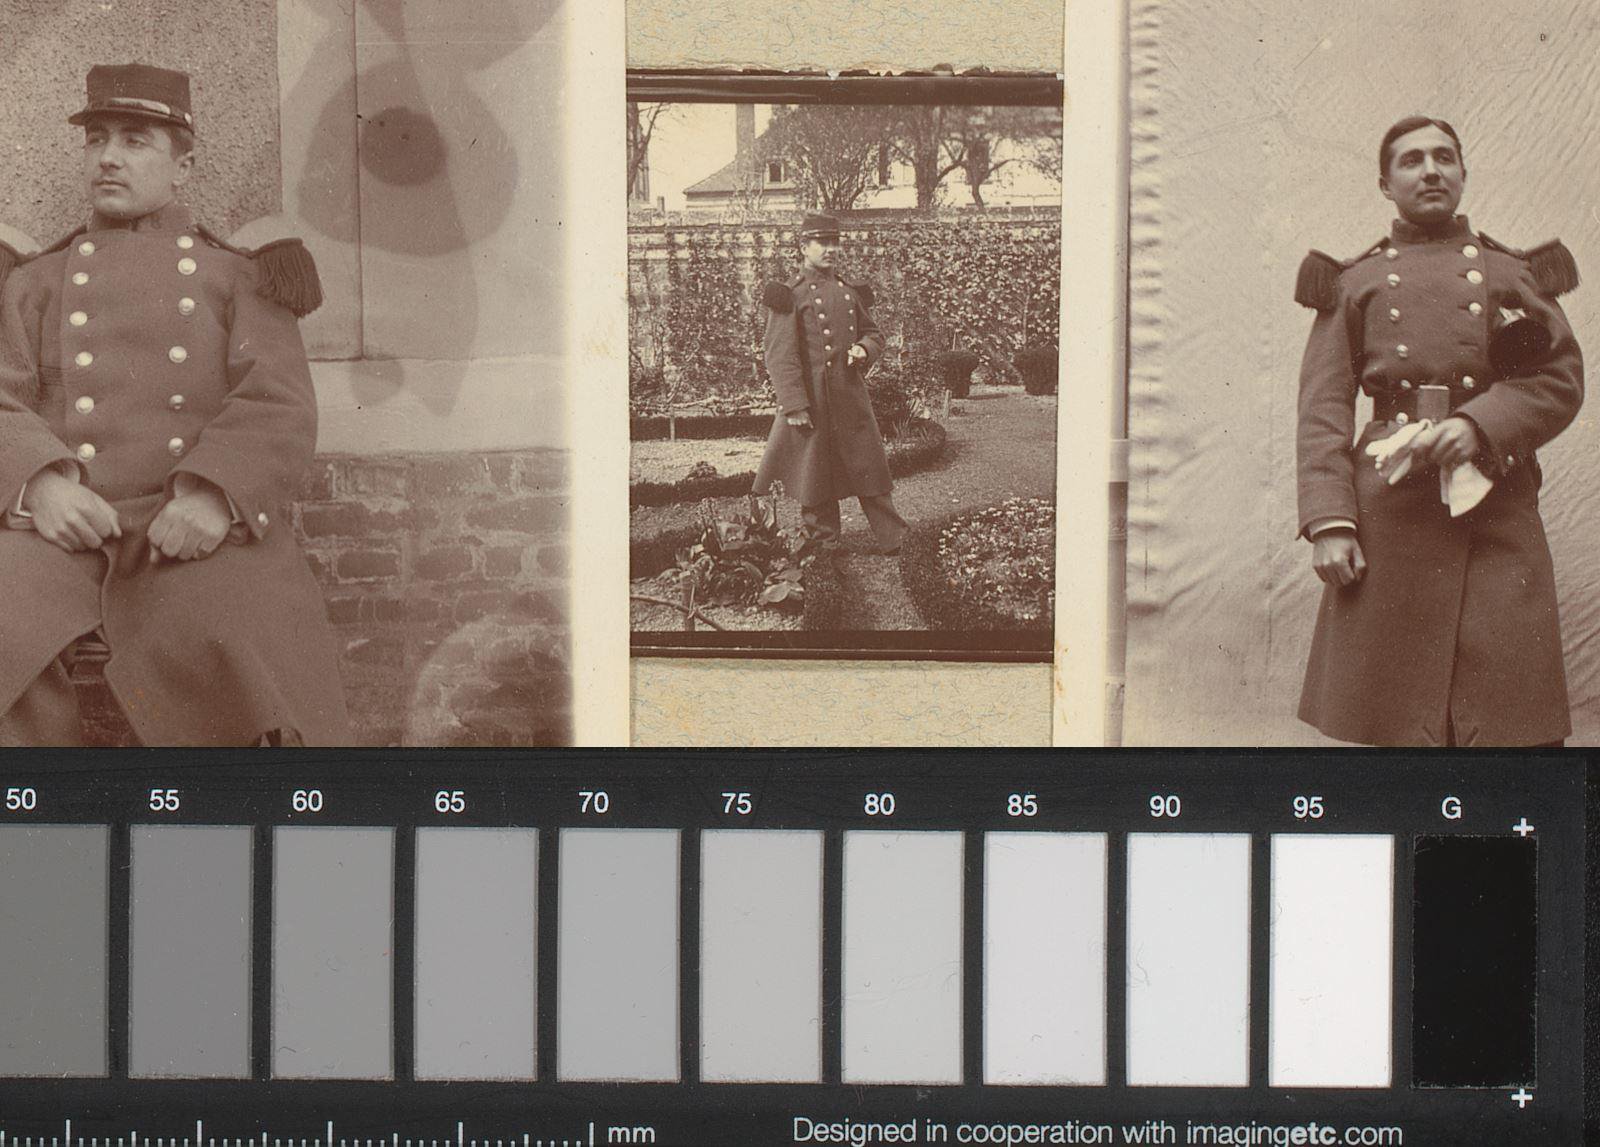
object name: album leaf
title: Portret van een man in militair uniform in tuin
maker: Anonymous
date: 1897-1900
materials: paper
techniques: gelatin silver print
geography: france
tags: garden, adult man, historical persons, (military) uniforms, france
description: Over de foto is een ander negatief afgedrukt van een voorstelling van bomen.